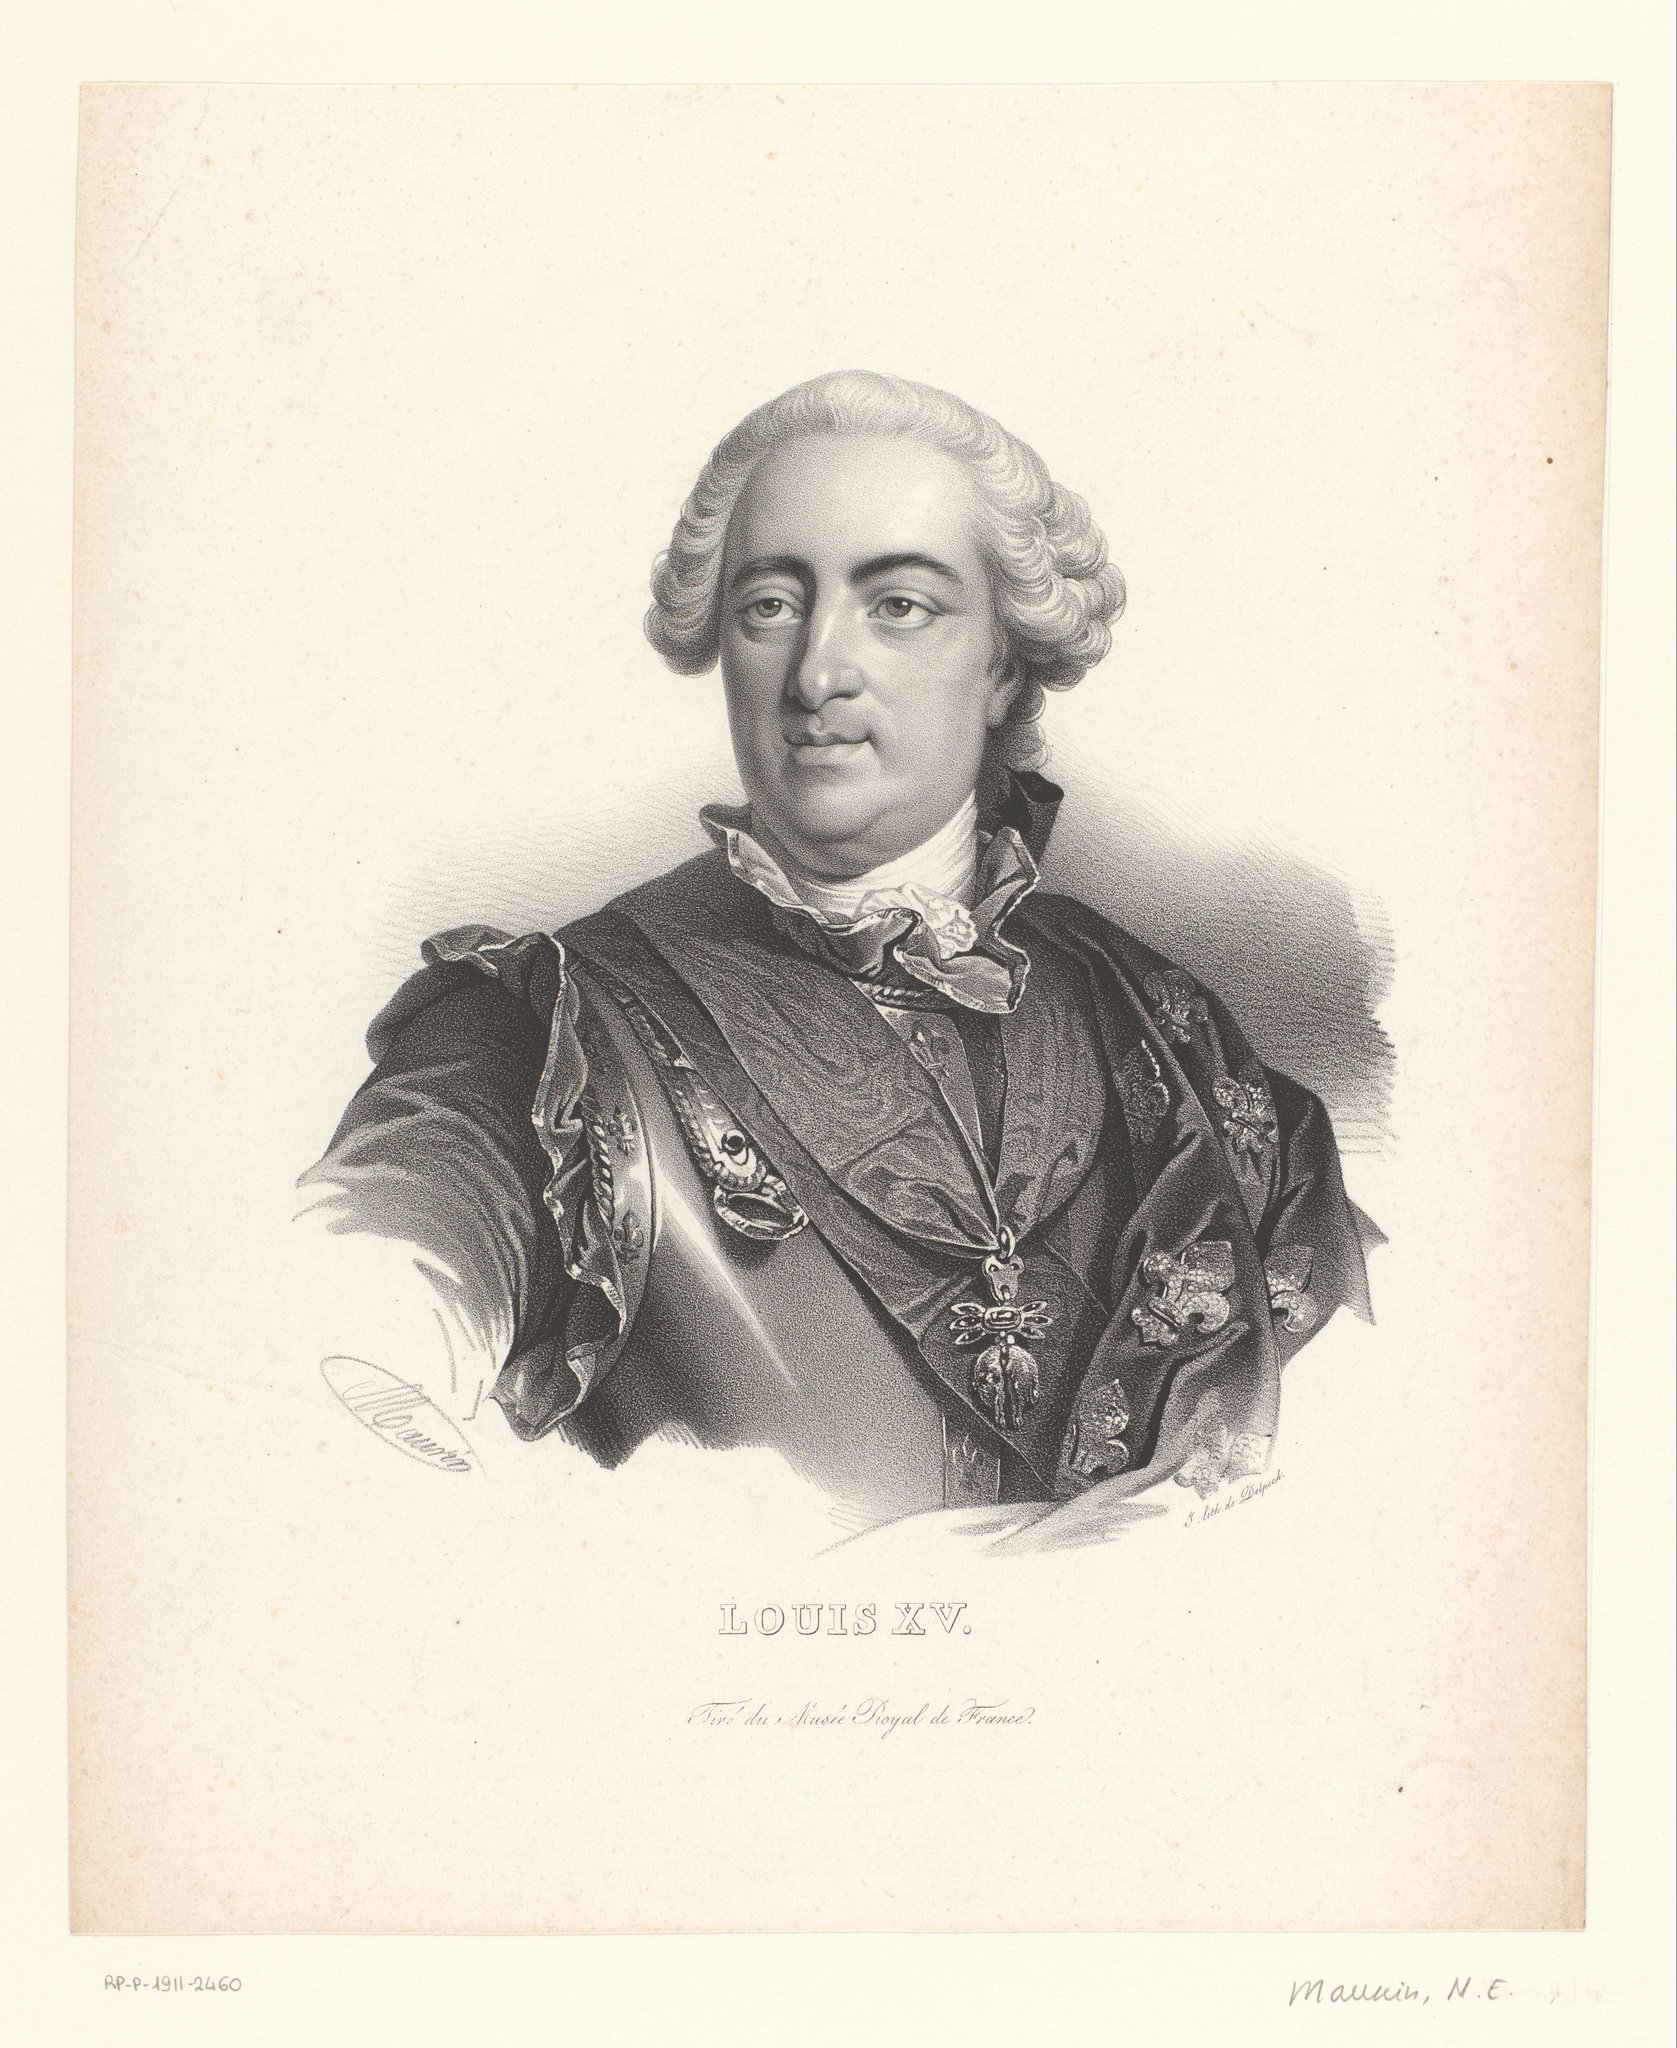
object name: print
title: Portret van Lodewijk XV, koning van Frankrijk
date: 1825-1842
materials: paper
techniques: lithograph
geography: paris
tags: louis xv of france, historical persons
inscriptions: collector's mark: Lugt 2228